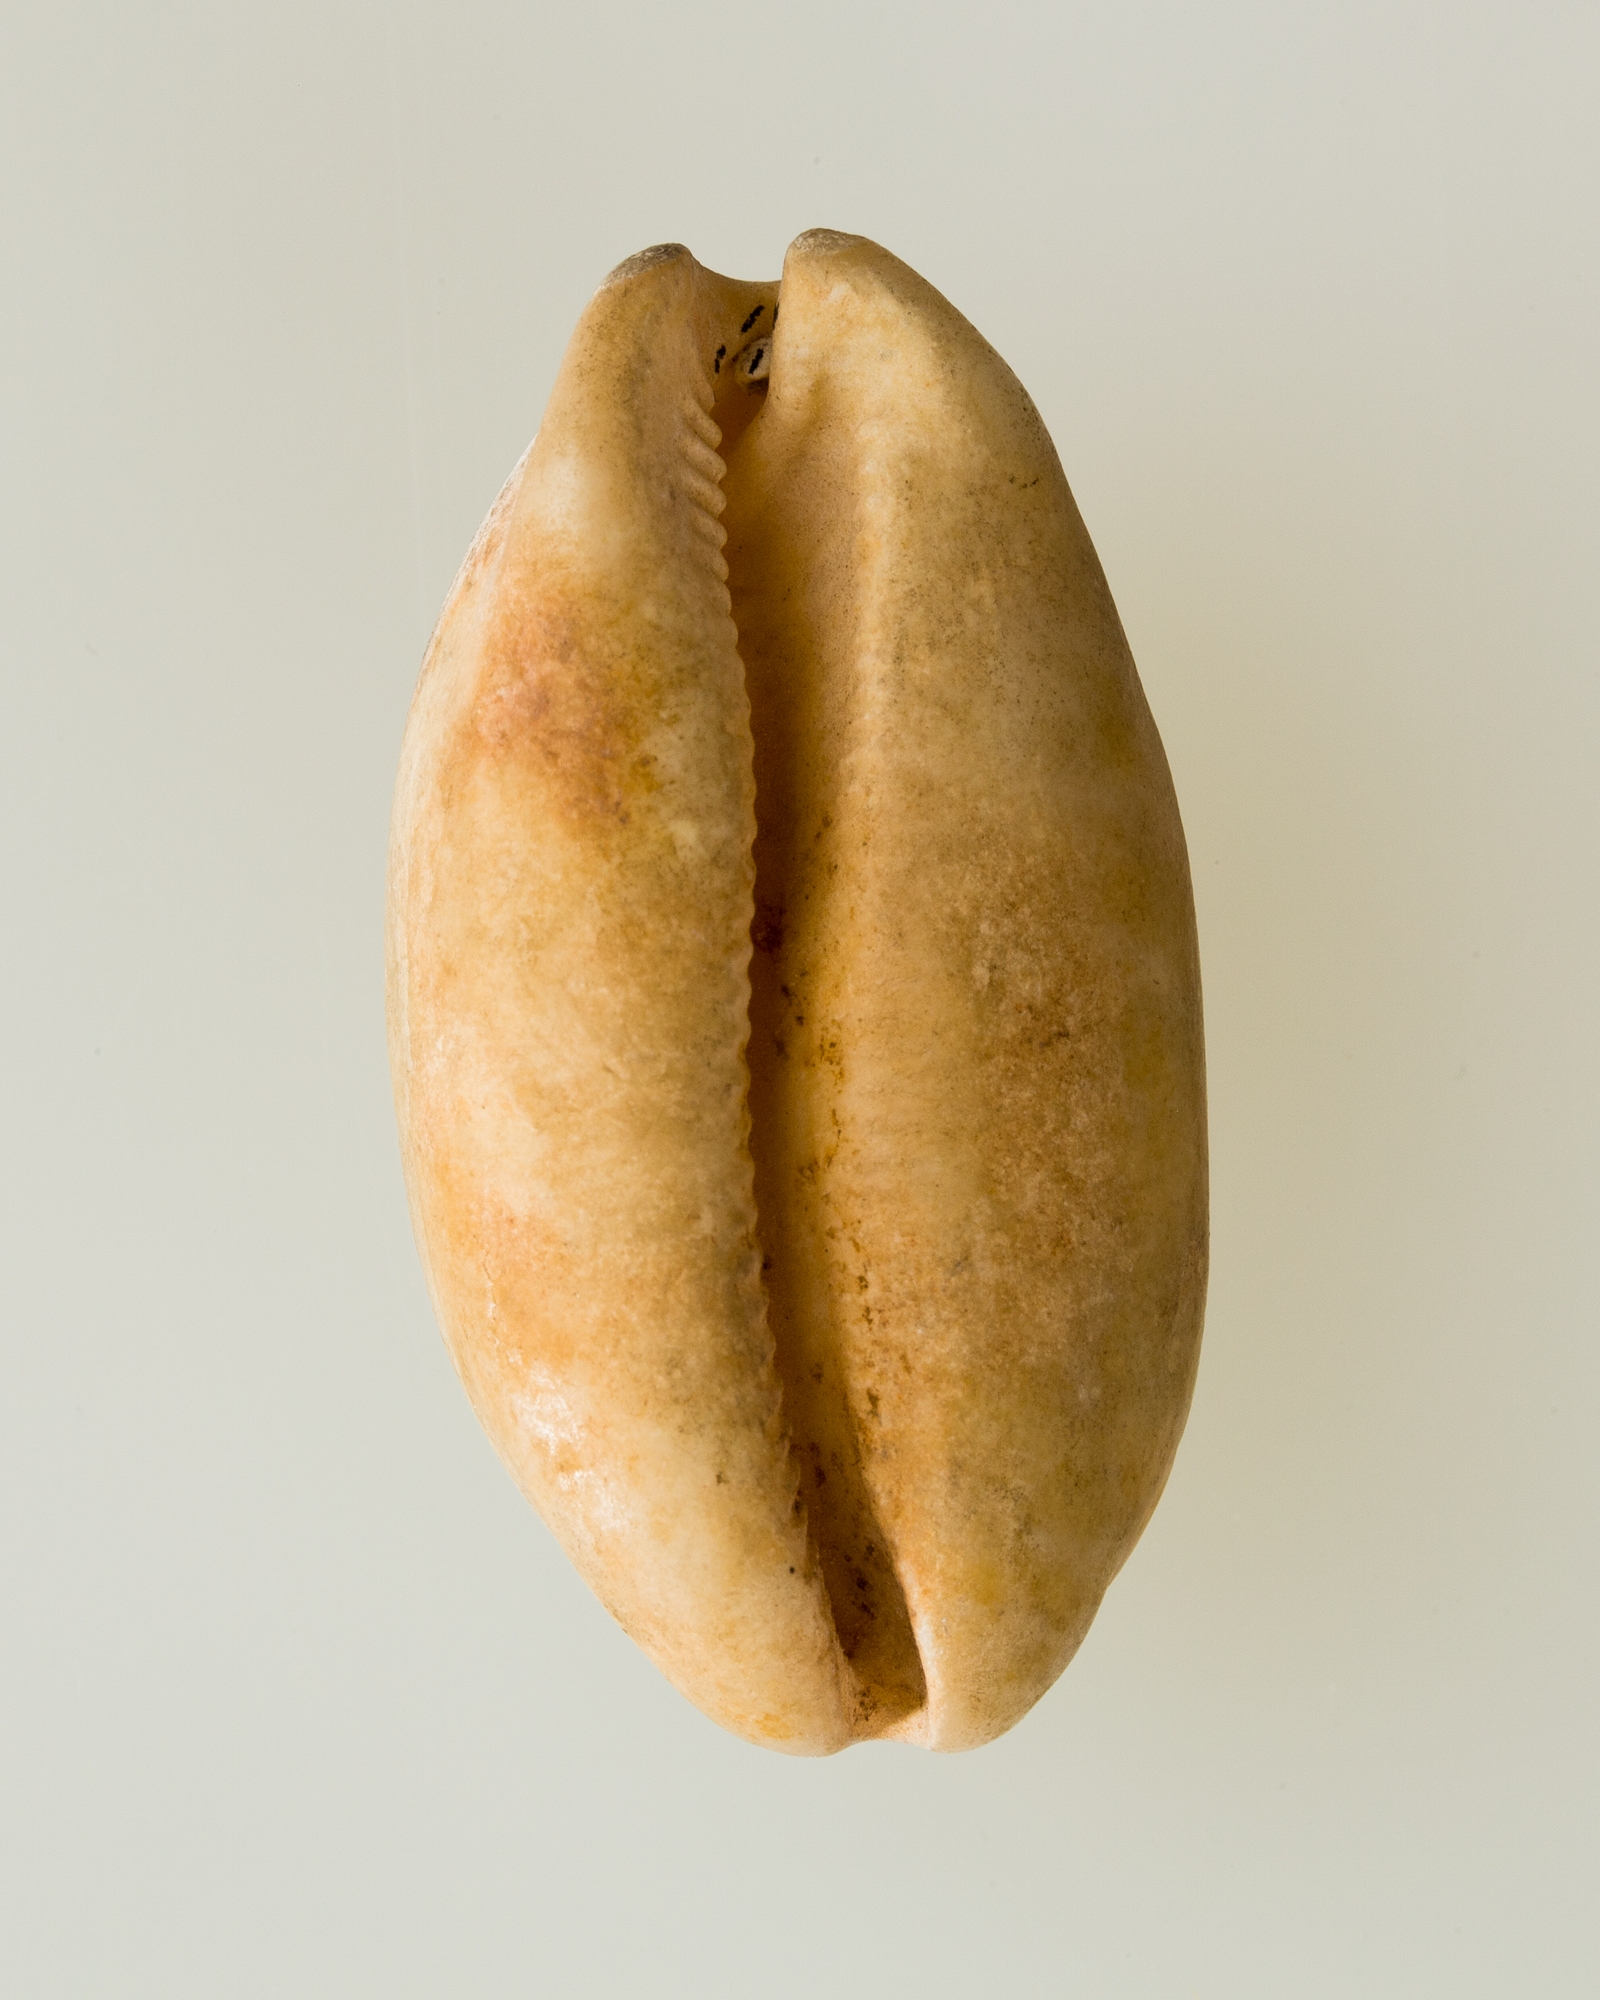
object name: pendant, shell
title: Shell pendant or bead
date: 3850-2960 BCE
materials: shell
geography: egypt